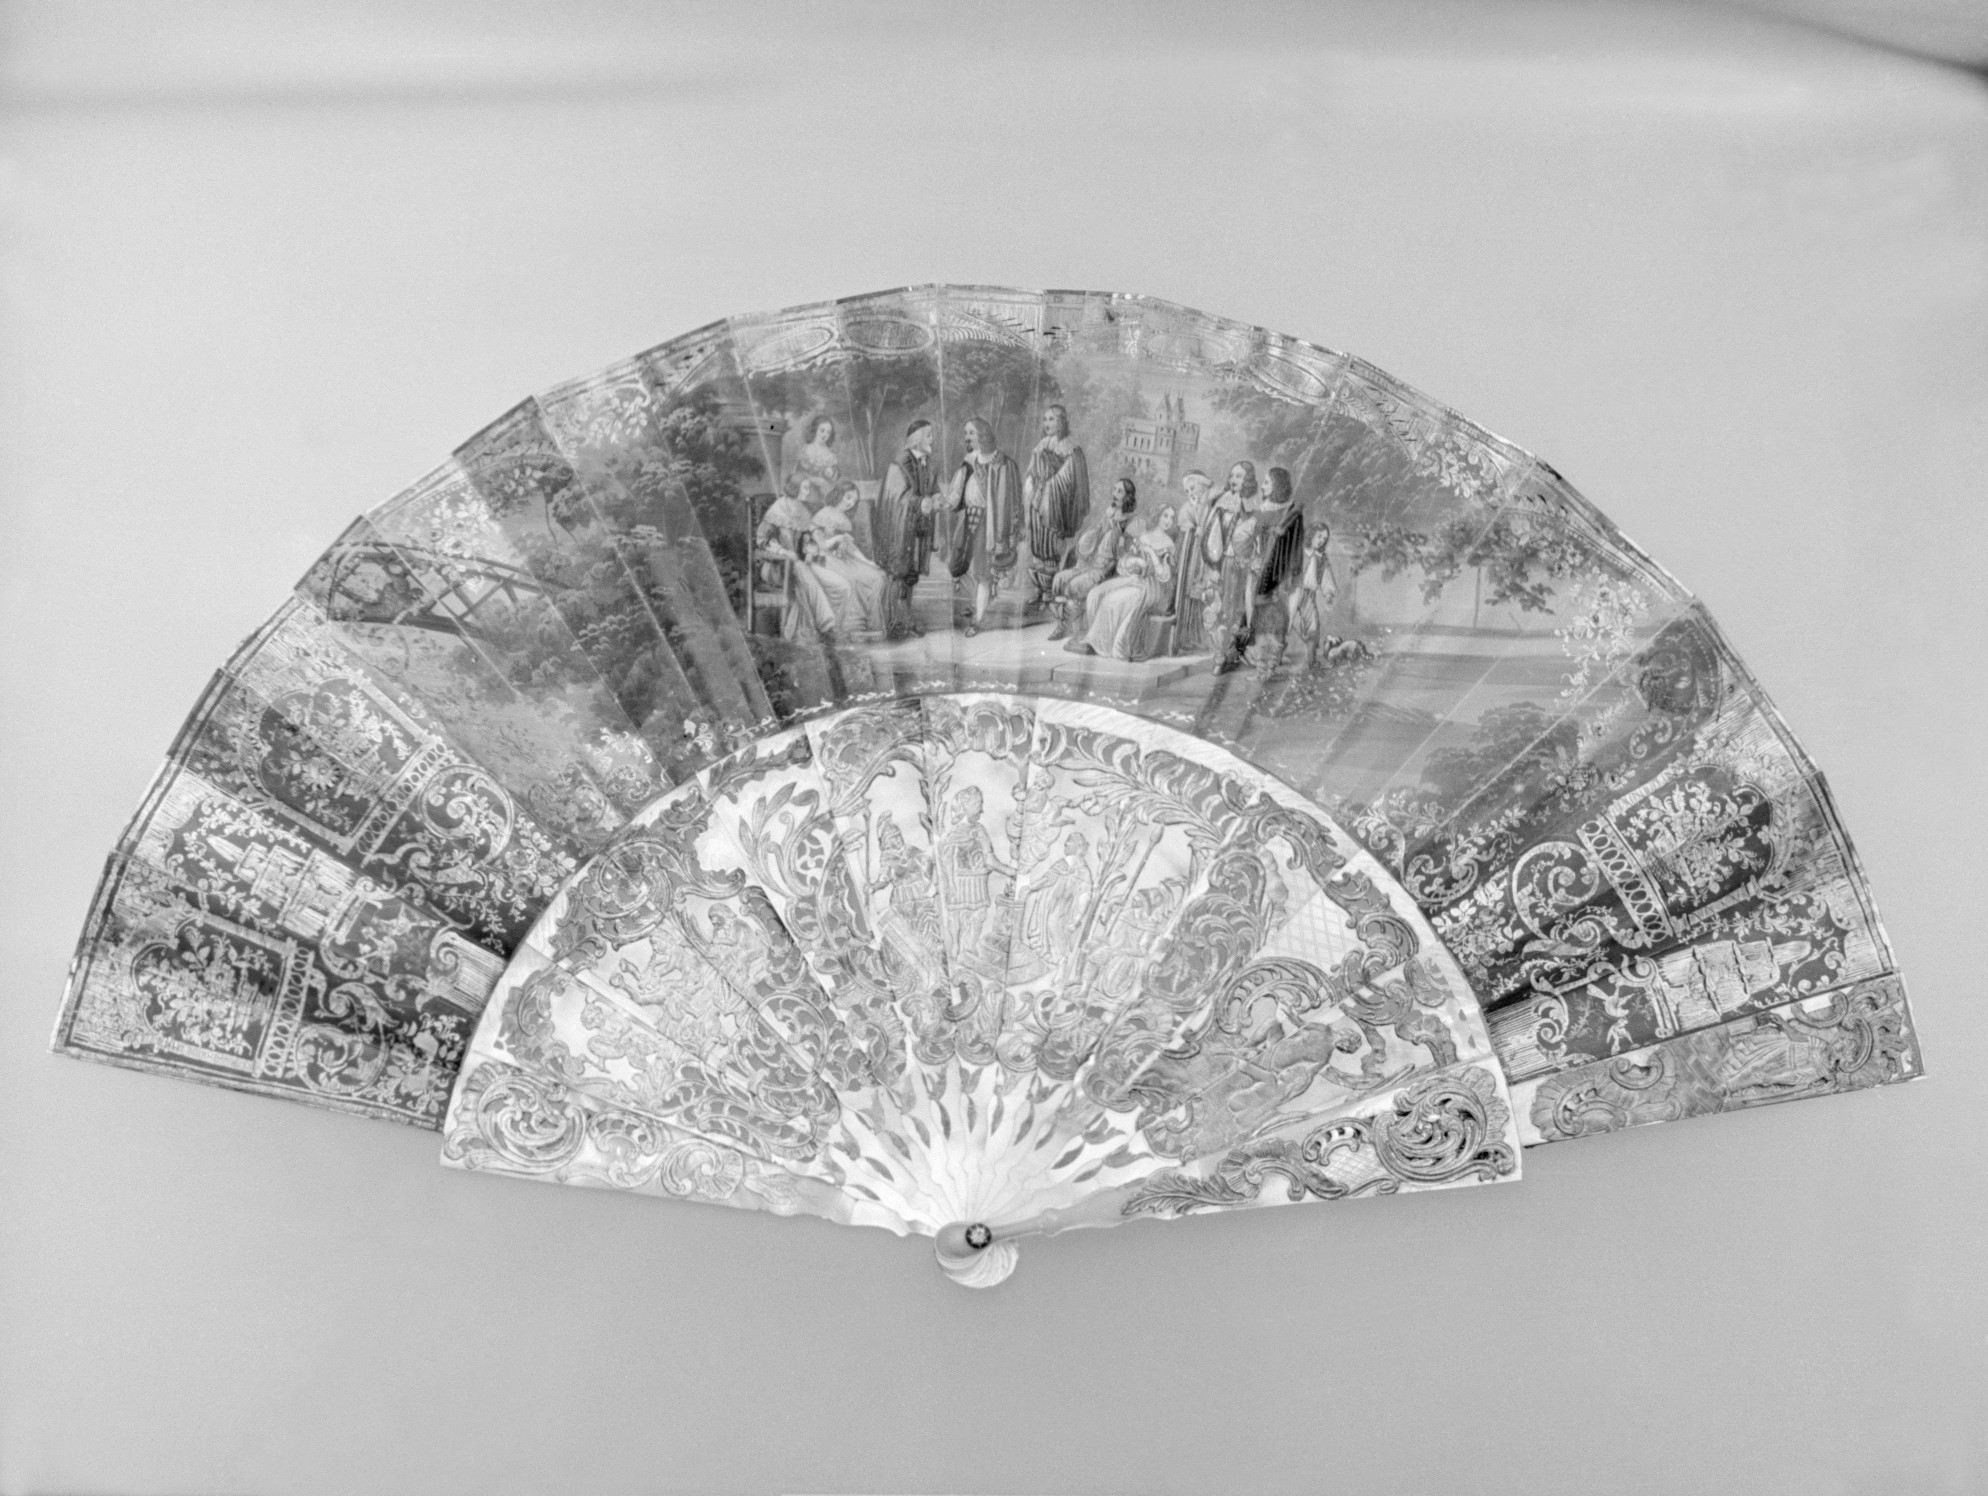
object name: fan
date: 1834-1866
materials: glass, gold, mother of pearl, parchment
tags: men,women